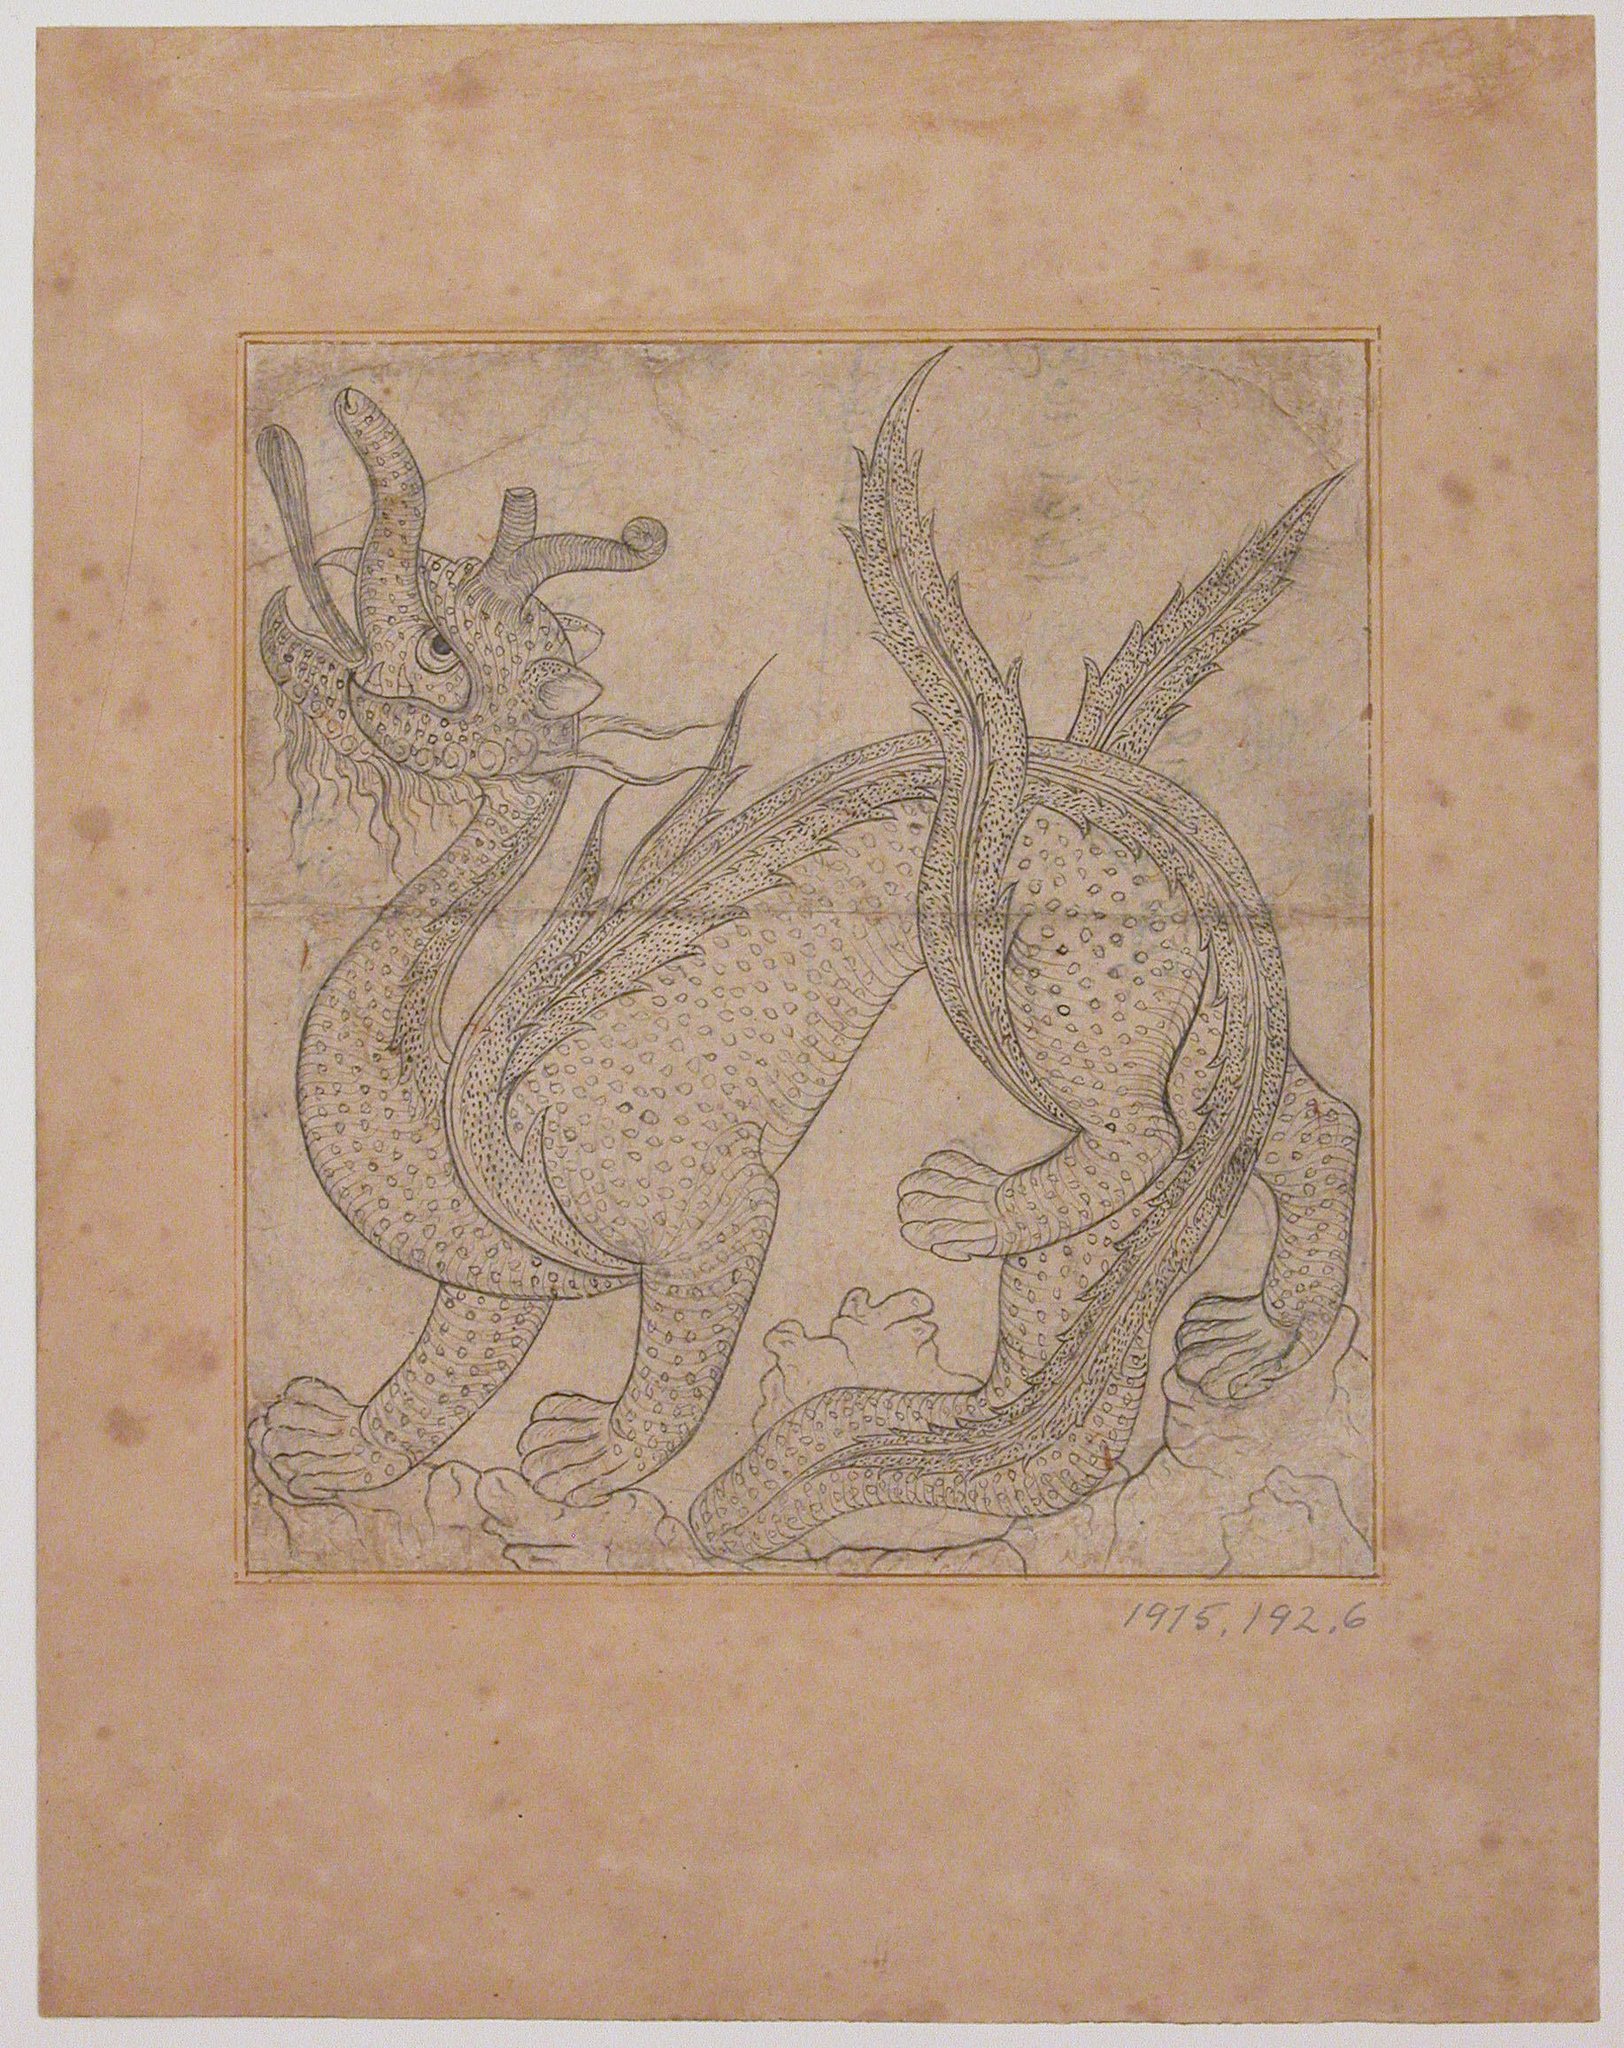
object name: illustrated single work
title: Dragon in Rocky Landscapes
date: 1601-1800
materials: ink, paper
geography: turkey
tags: dragons